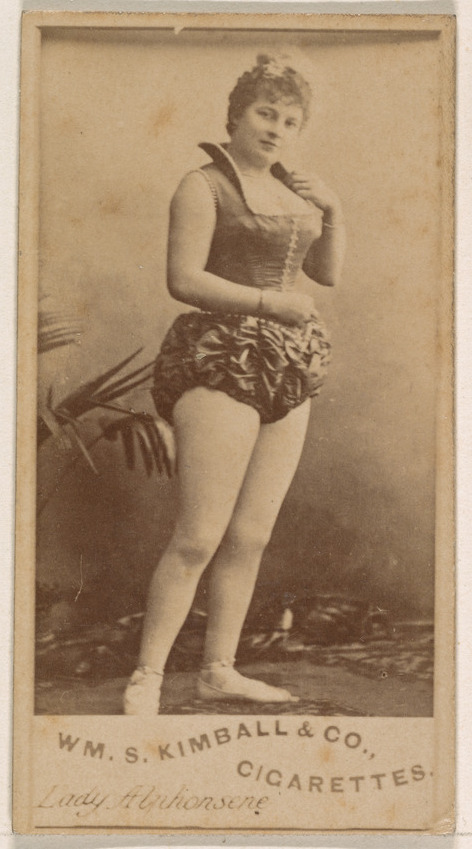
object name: photograph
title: Lady Alphonsene, from the Actresses series (N203) issued by Wm. S. Kimball & Co.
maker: william s. kimball & company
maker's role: publisher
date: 1889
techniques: color lithograph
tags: portraits,women,actresses